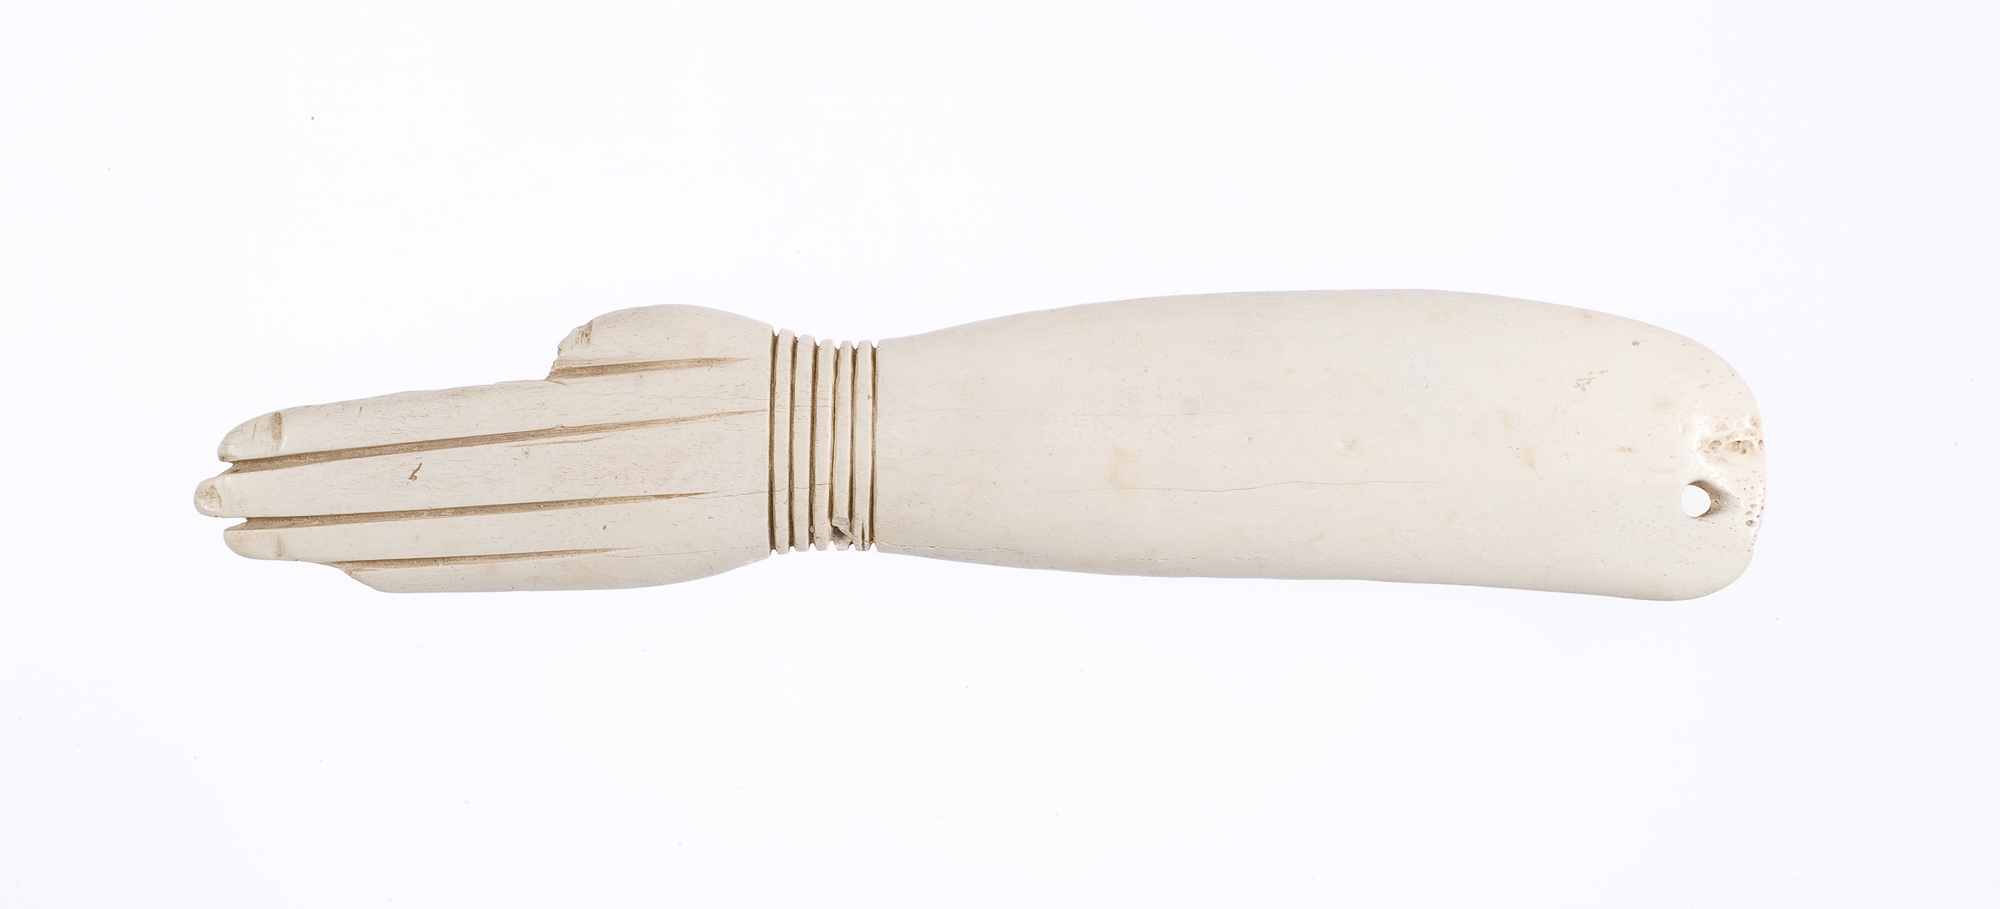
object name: music, clapper, arm, hand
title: Clapper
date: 1981-1640 BCE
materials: ivory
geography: egypt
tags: hands